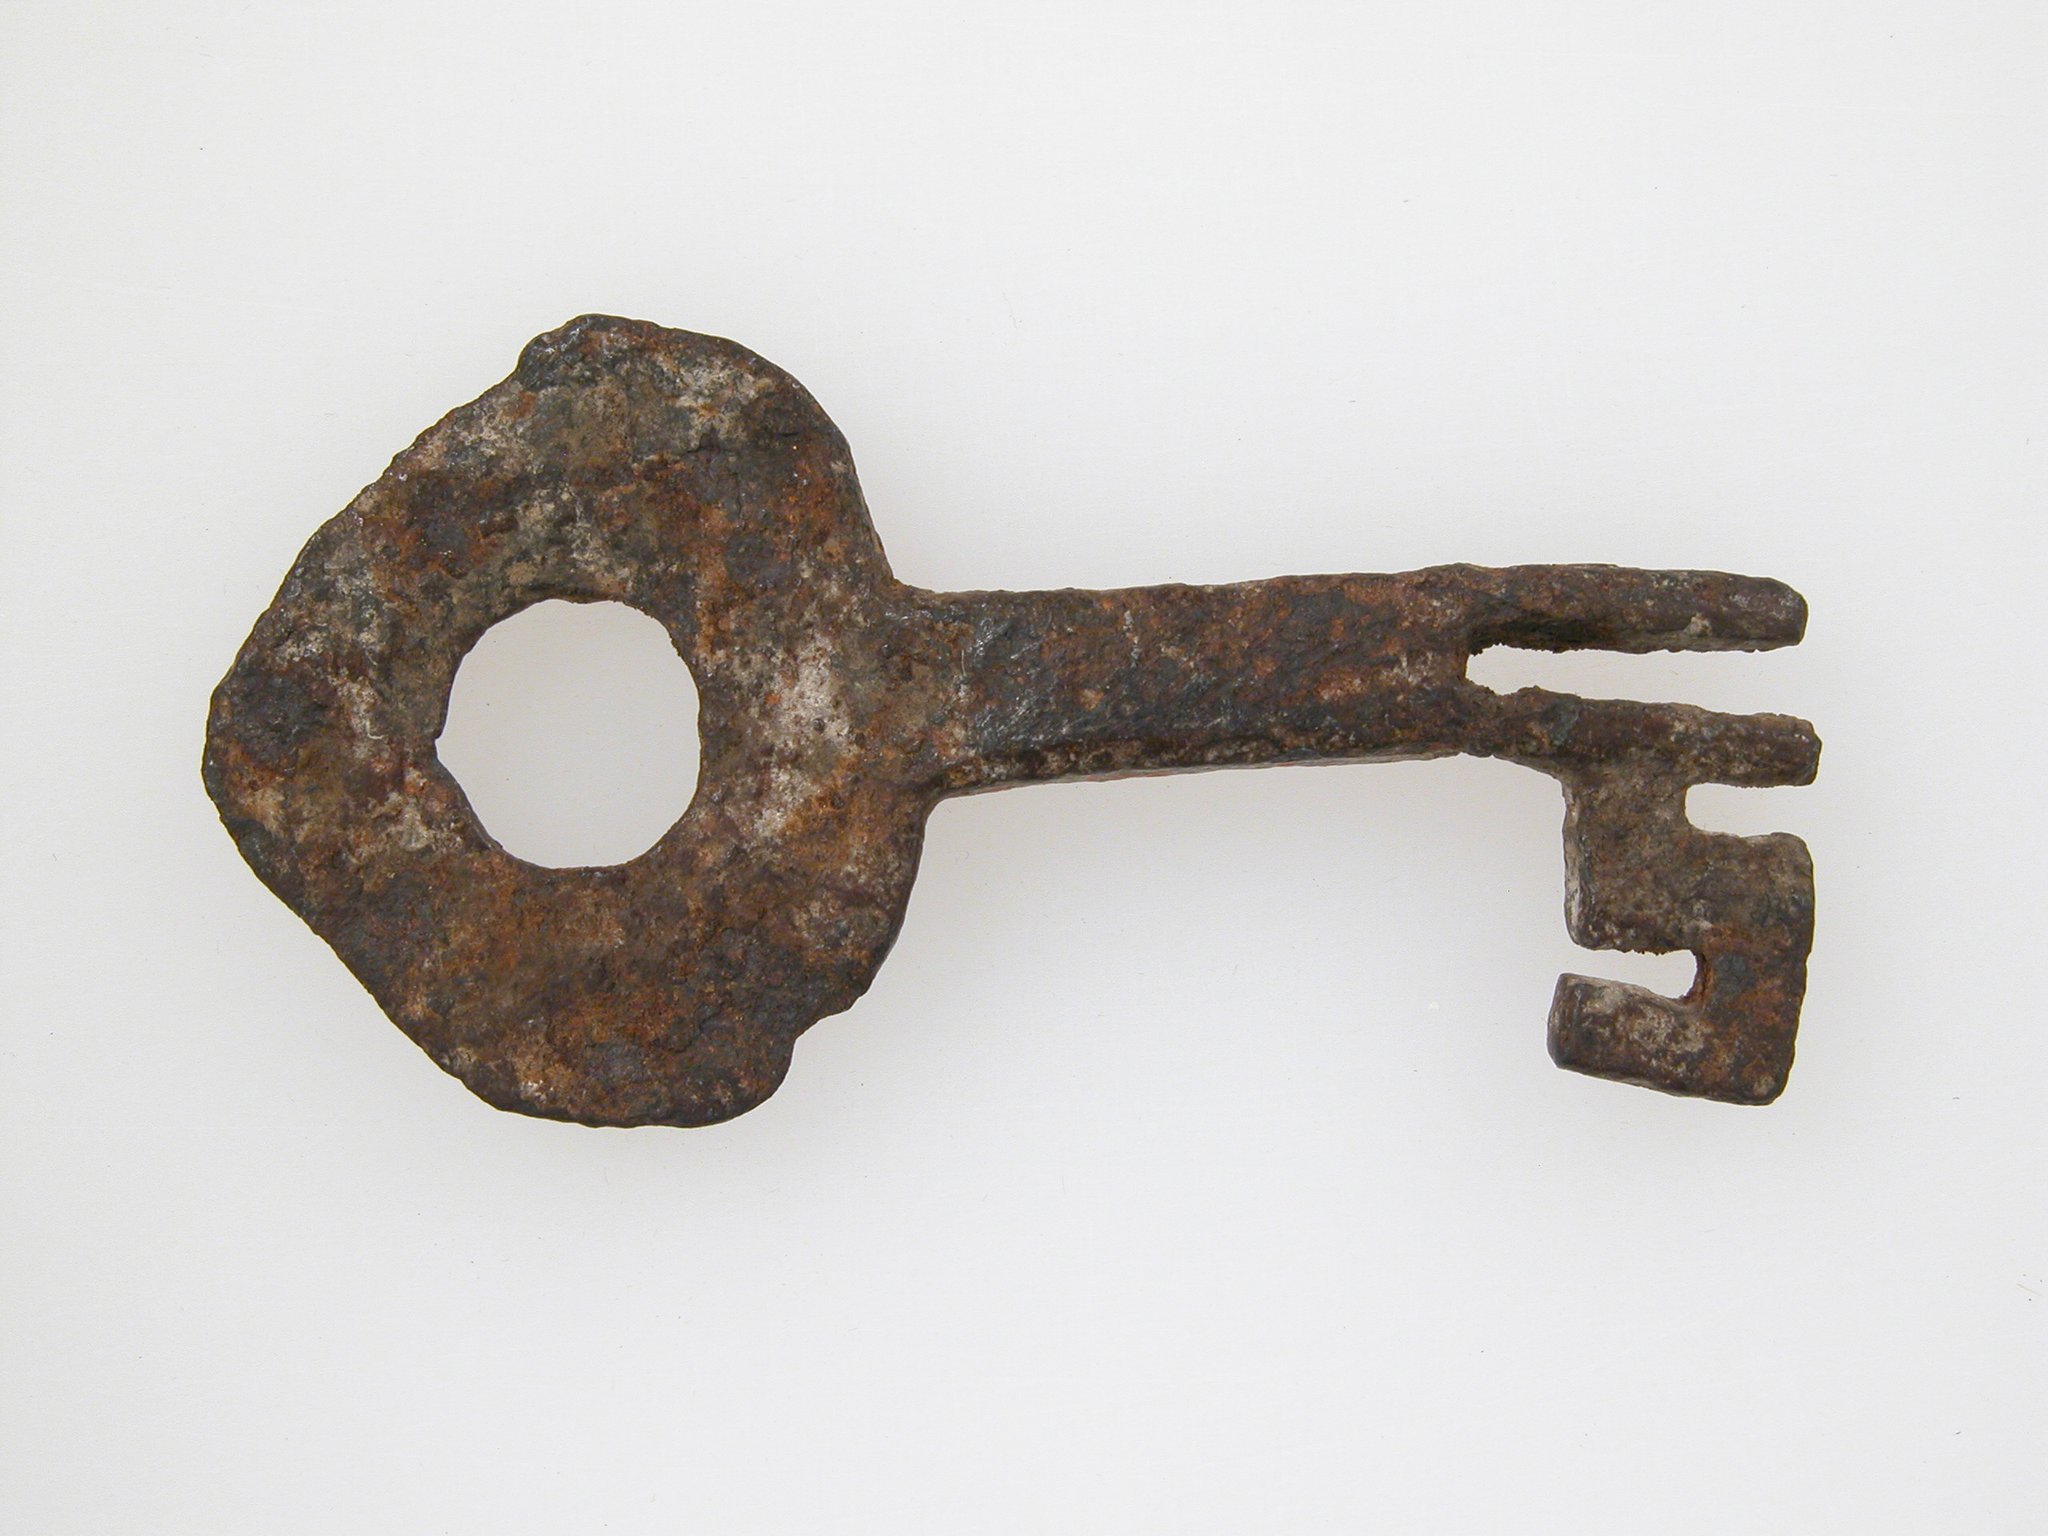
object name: key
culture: french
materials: iron